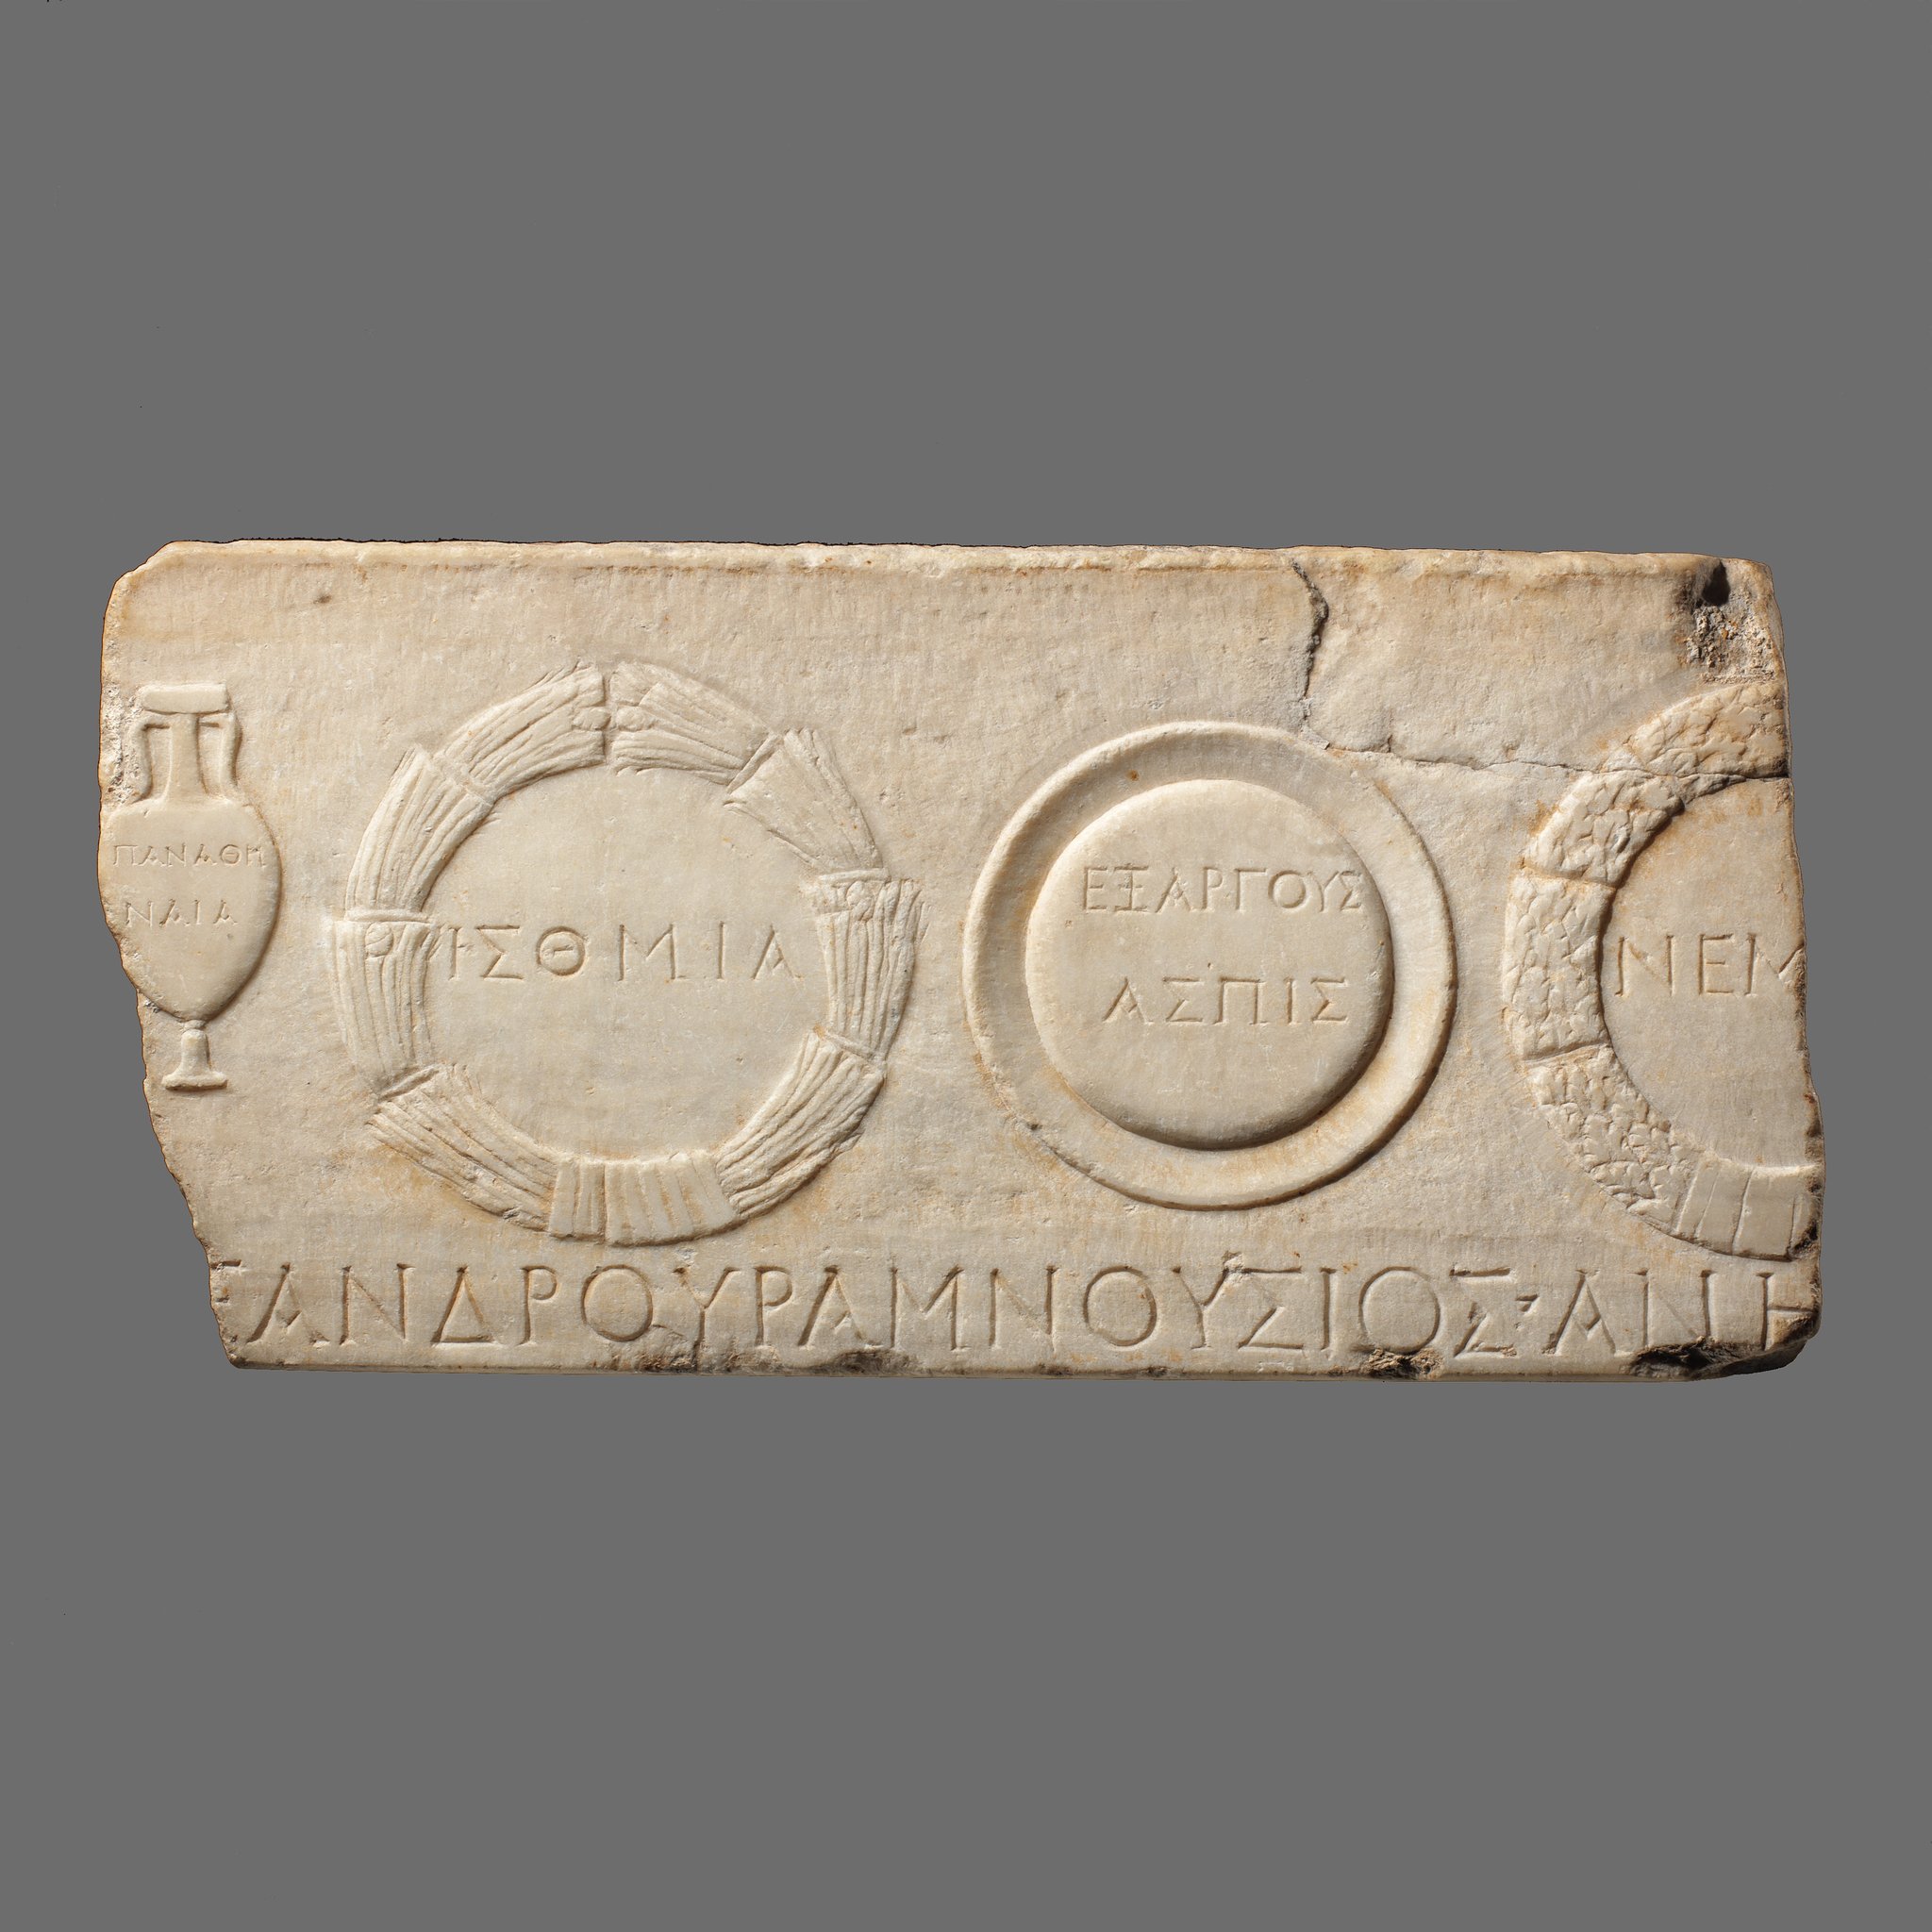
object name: relief with prize of panhellenic game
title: Marble relief fragment depicting athletic prizes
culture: roman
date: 101-200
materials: marble